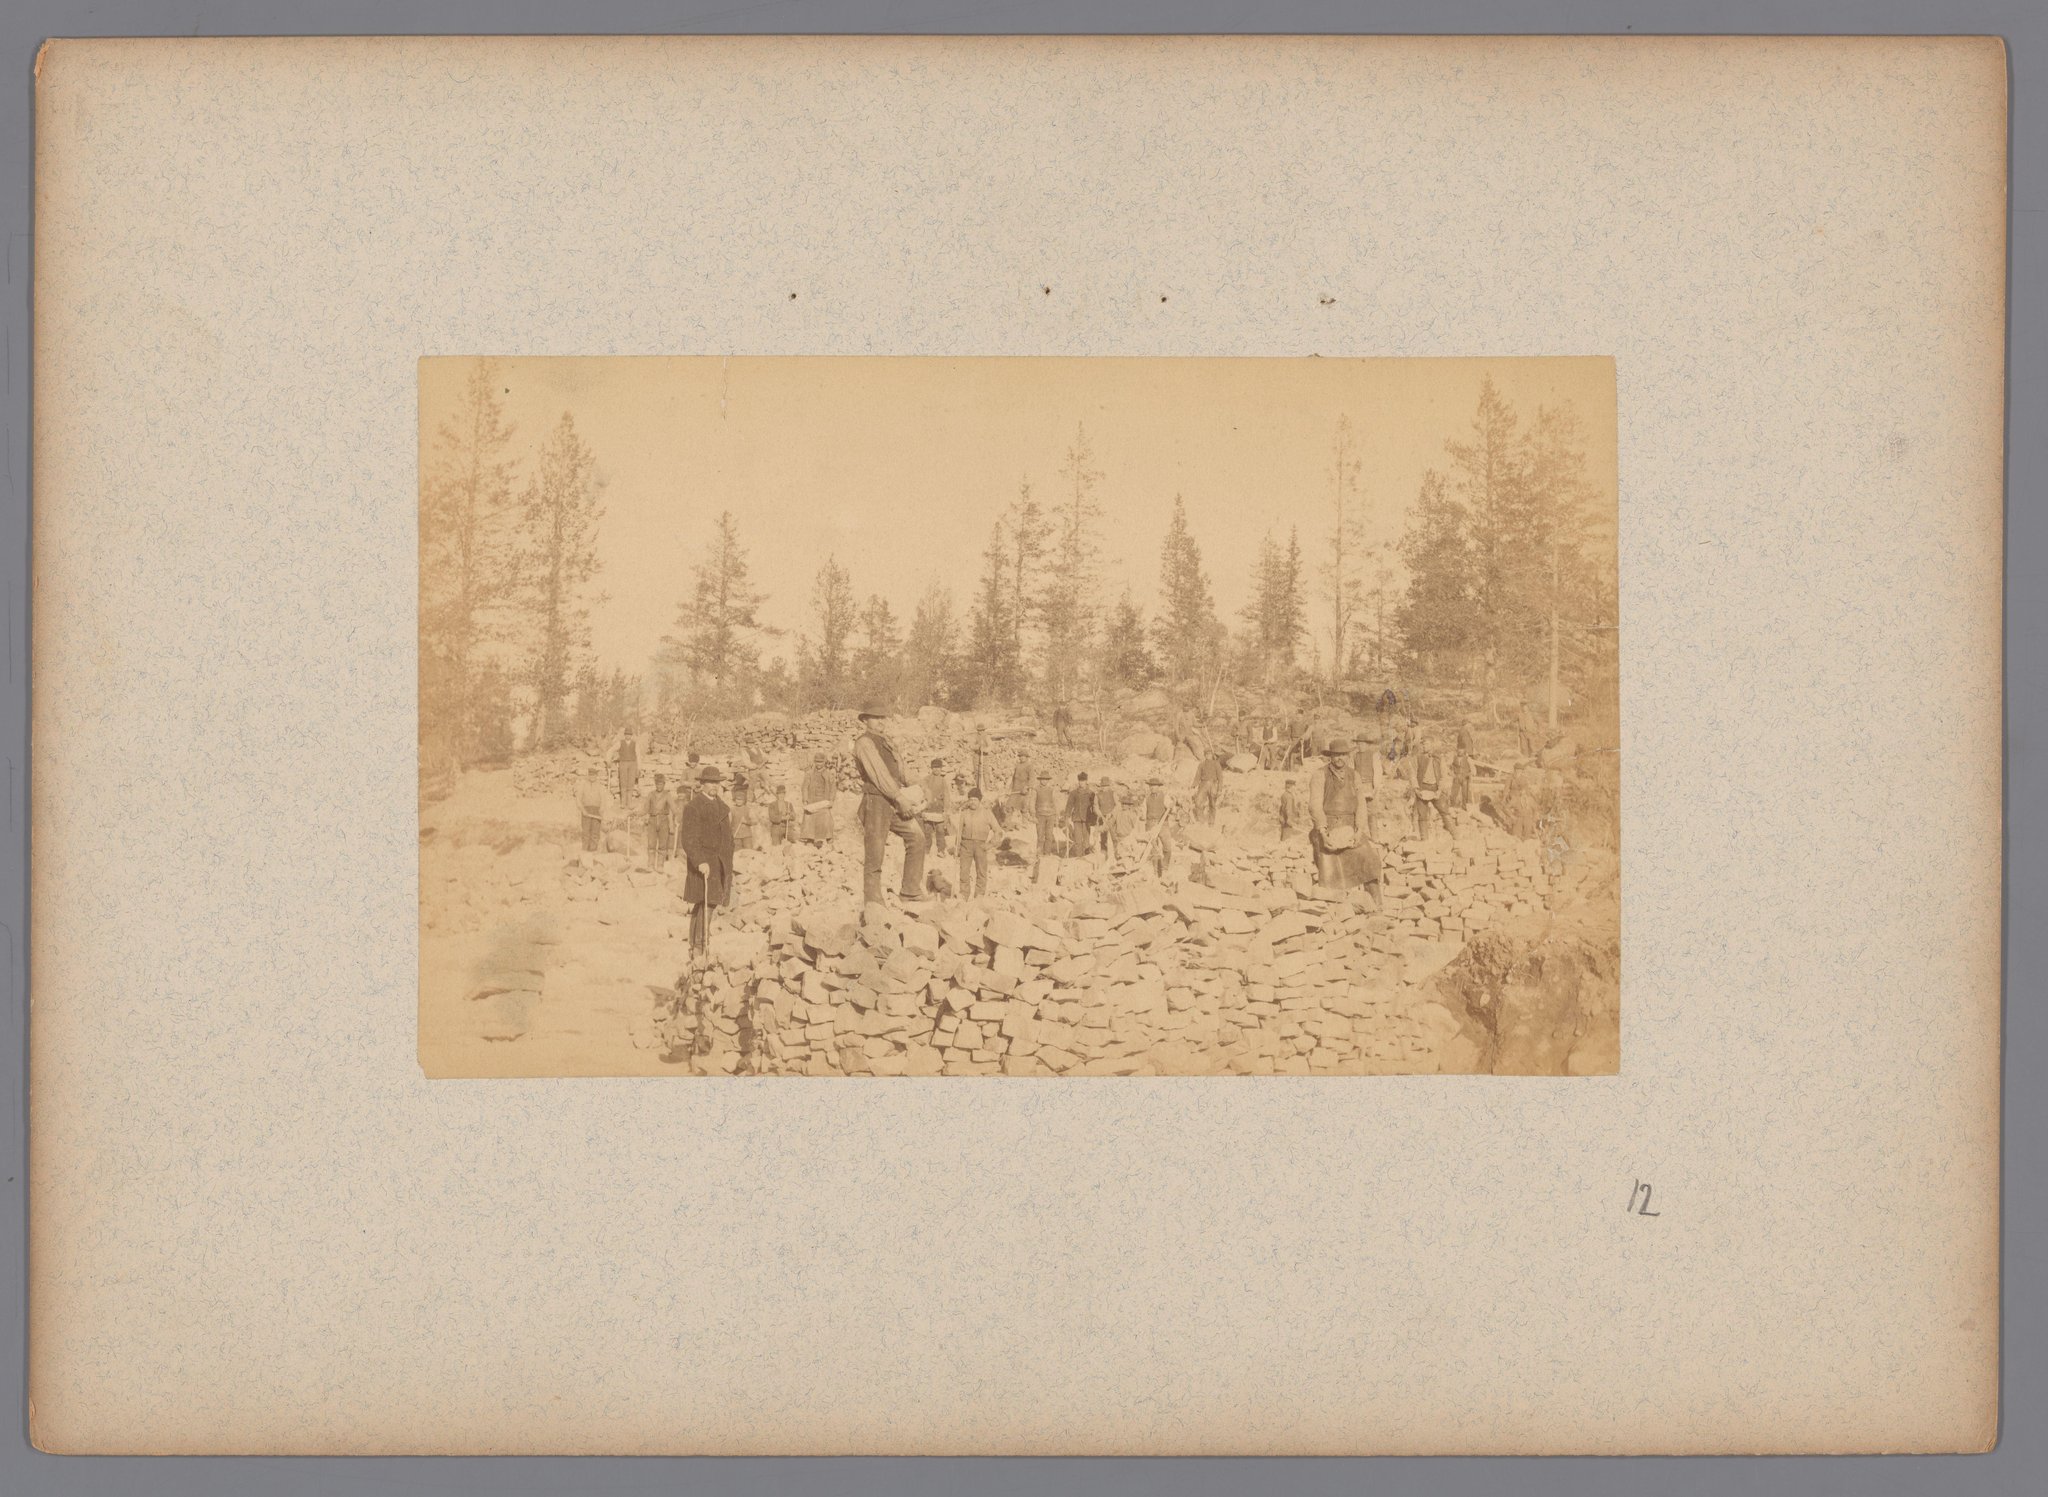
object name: photograph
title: Groep mannen, mogelijk mijnwerkers in Noord-Zweden tussen Luleå en Narvik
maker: Anonymous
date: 1891-1900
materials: cardboard, paper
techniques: albumen print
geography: sweden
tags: miner